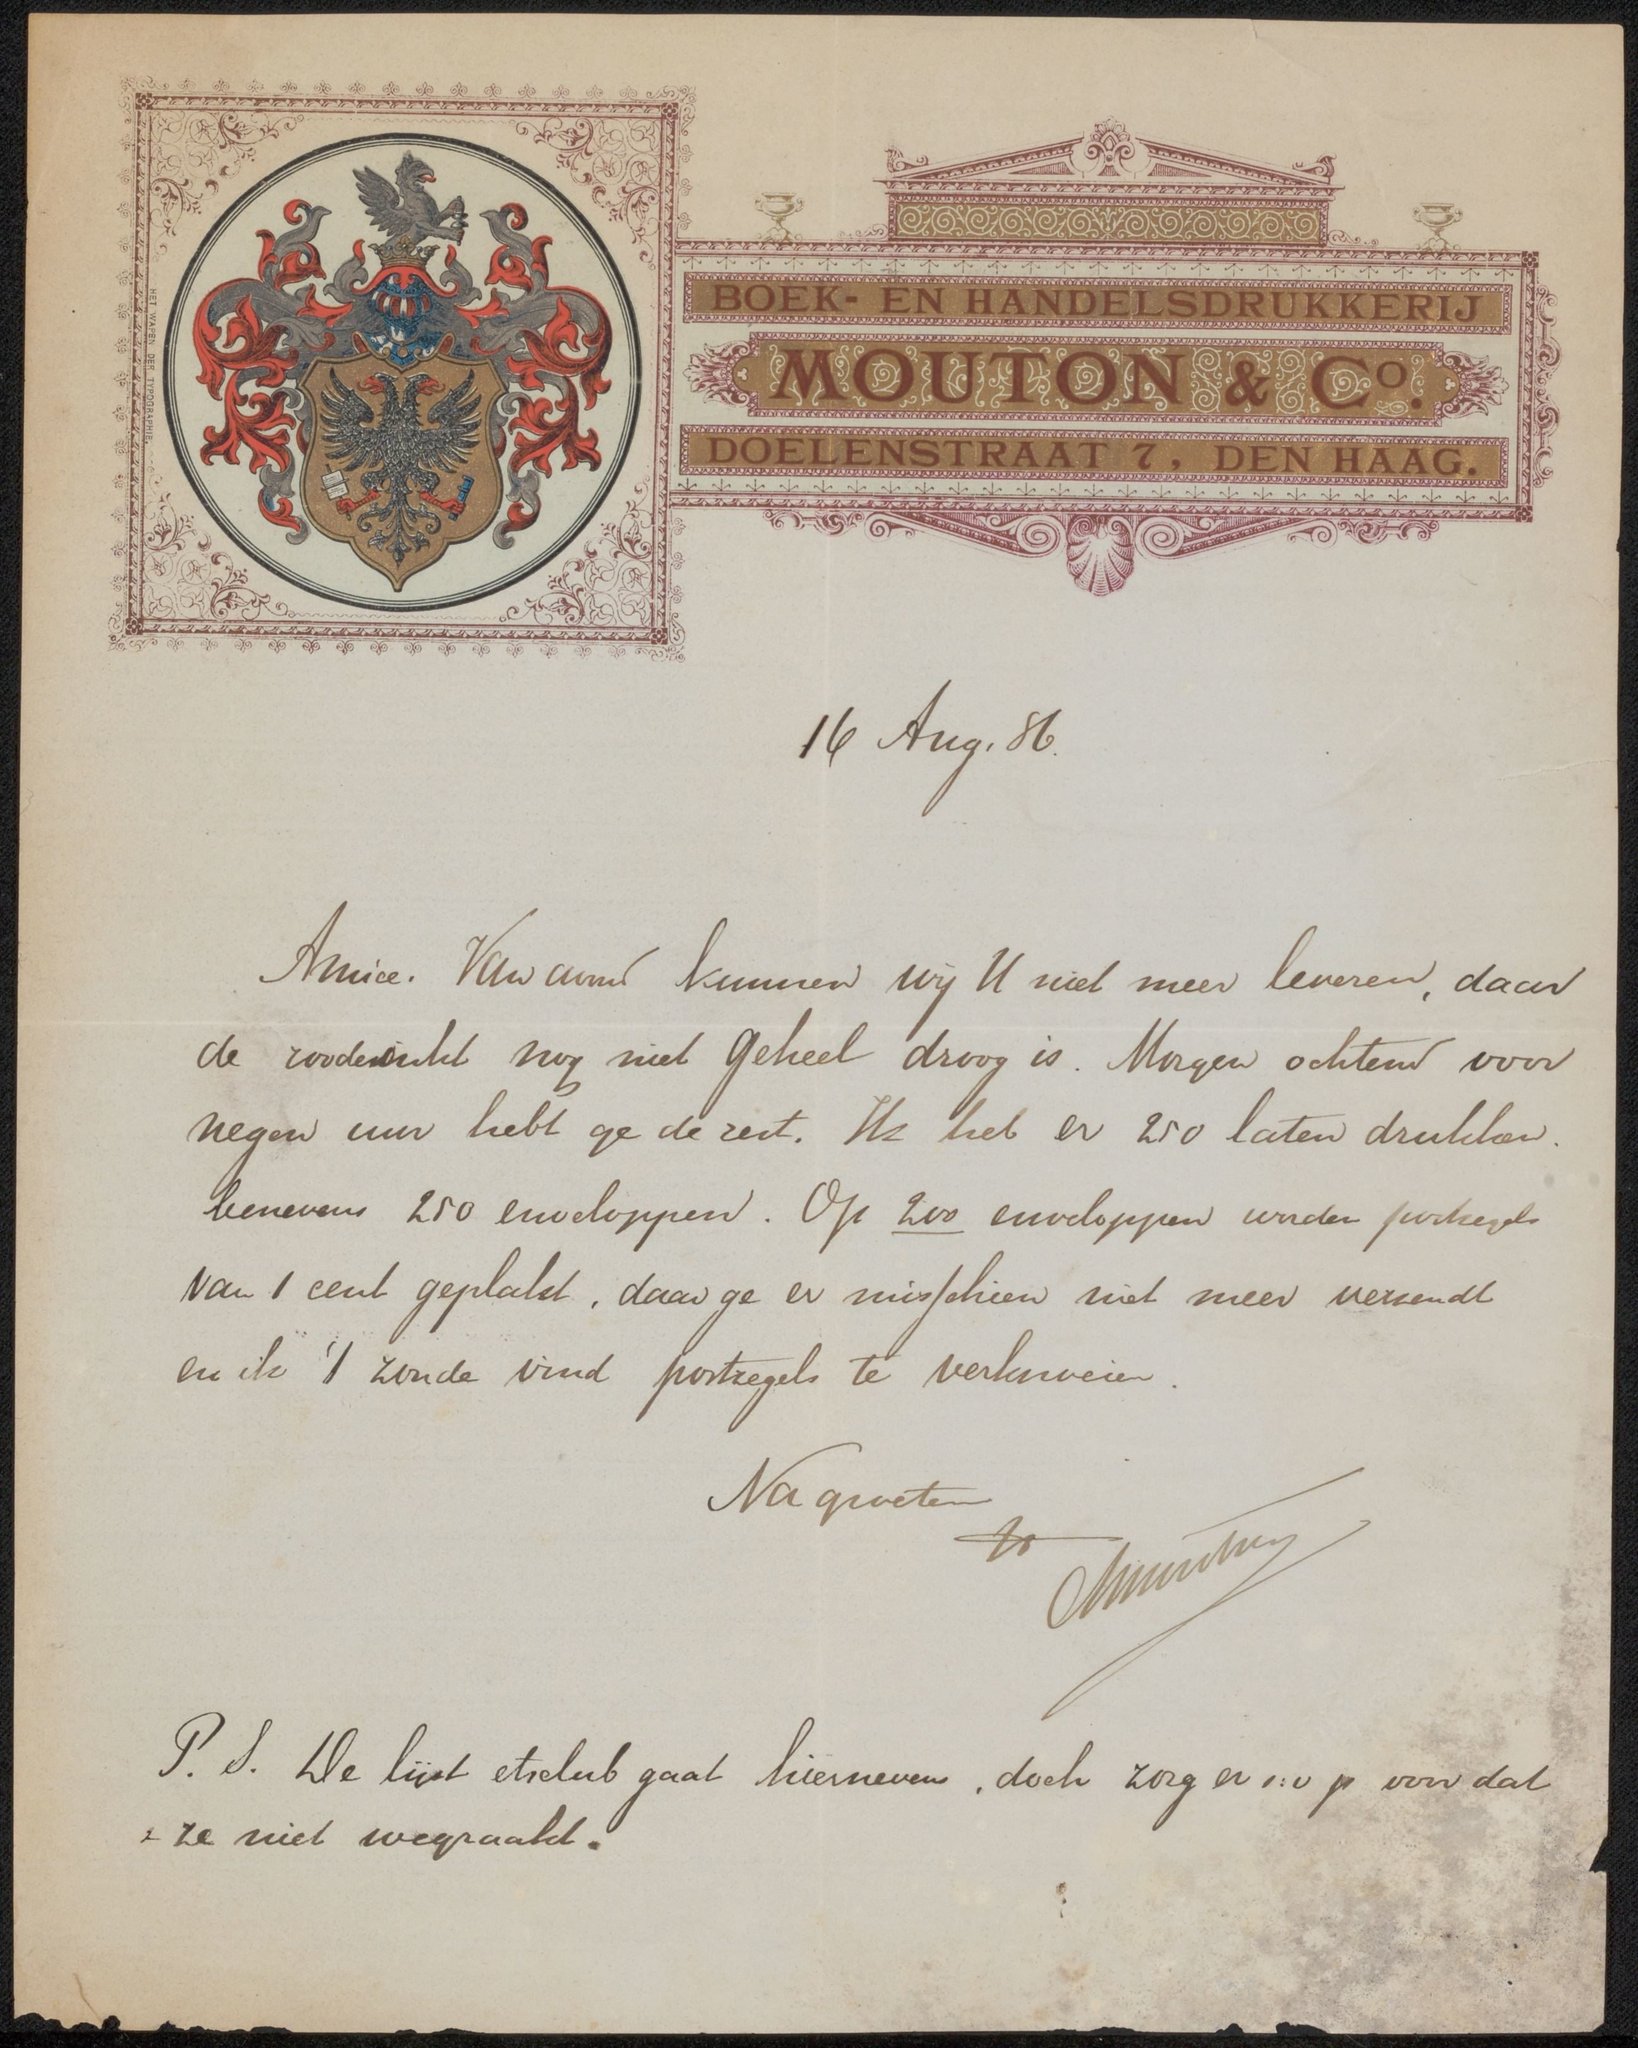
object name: letter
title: Brief aan Philip Zilcken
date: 1886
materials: ink, paper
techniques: pen, printing, writing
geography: the hague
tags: the hague, painter, draughtsman, philip zilcken, printed matter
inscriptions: collector's mark: ‘RPK’